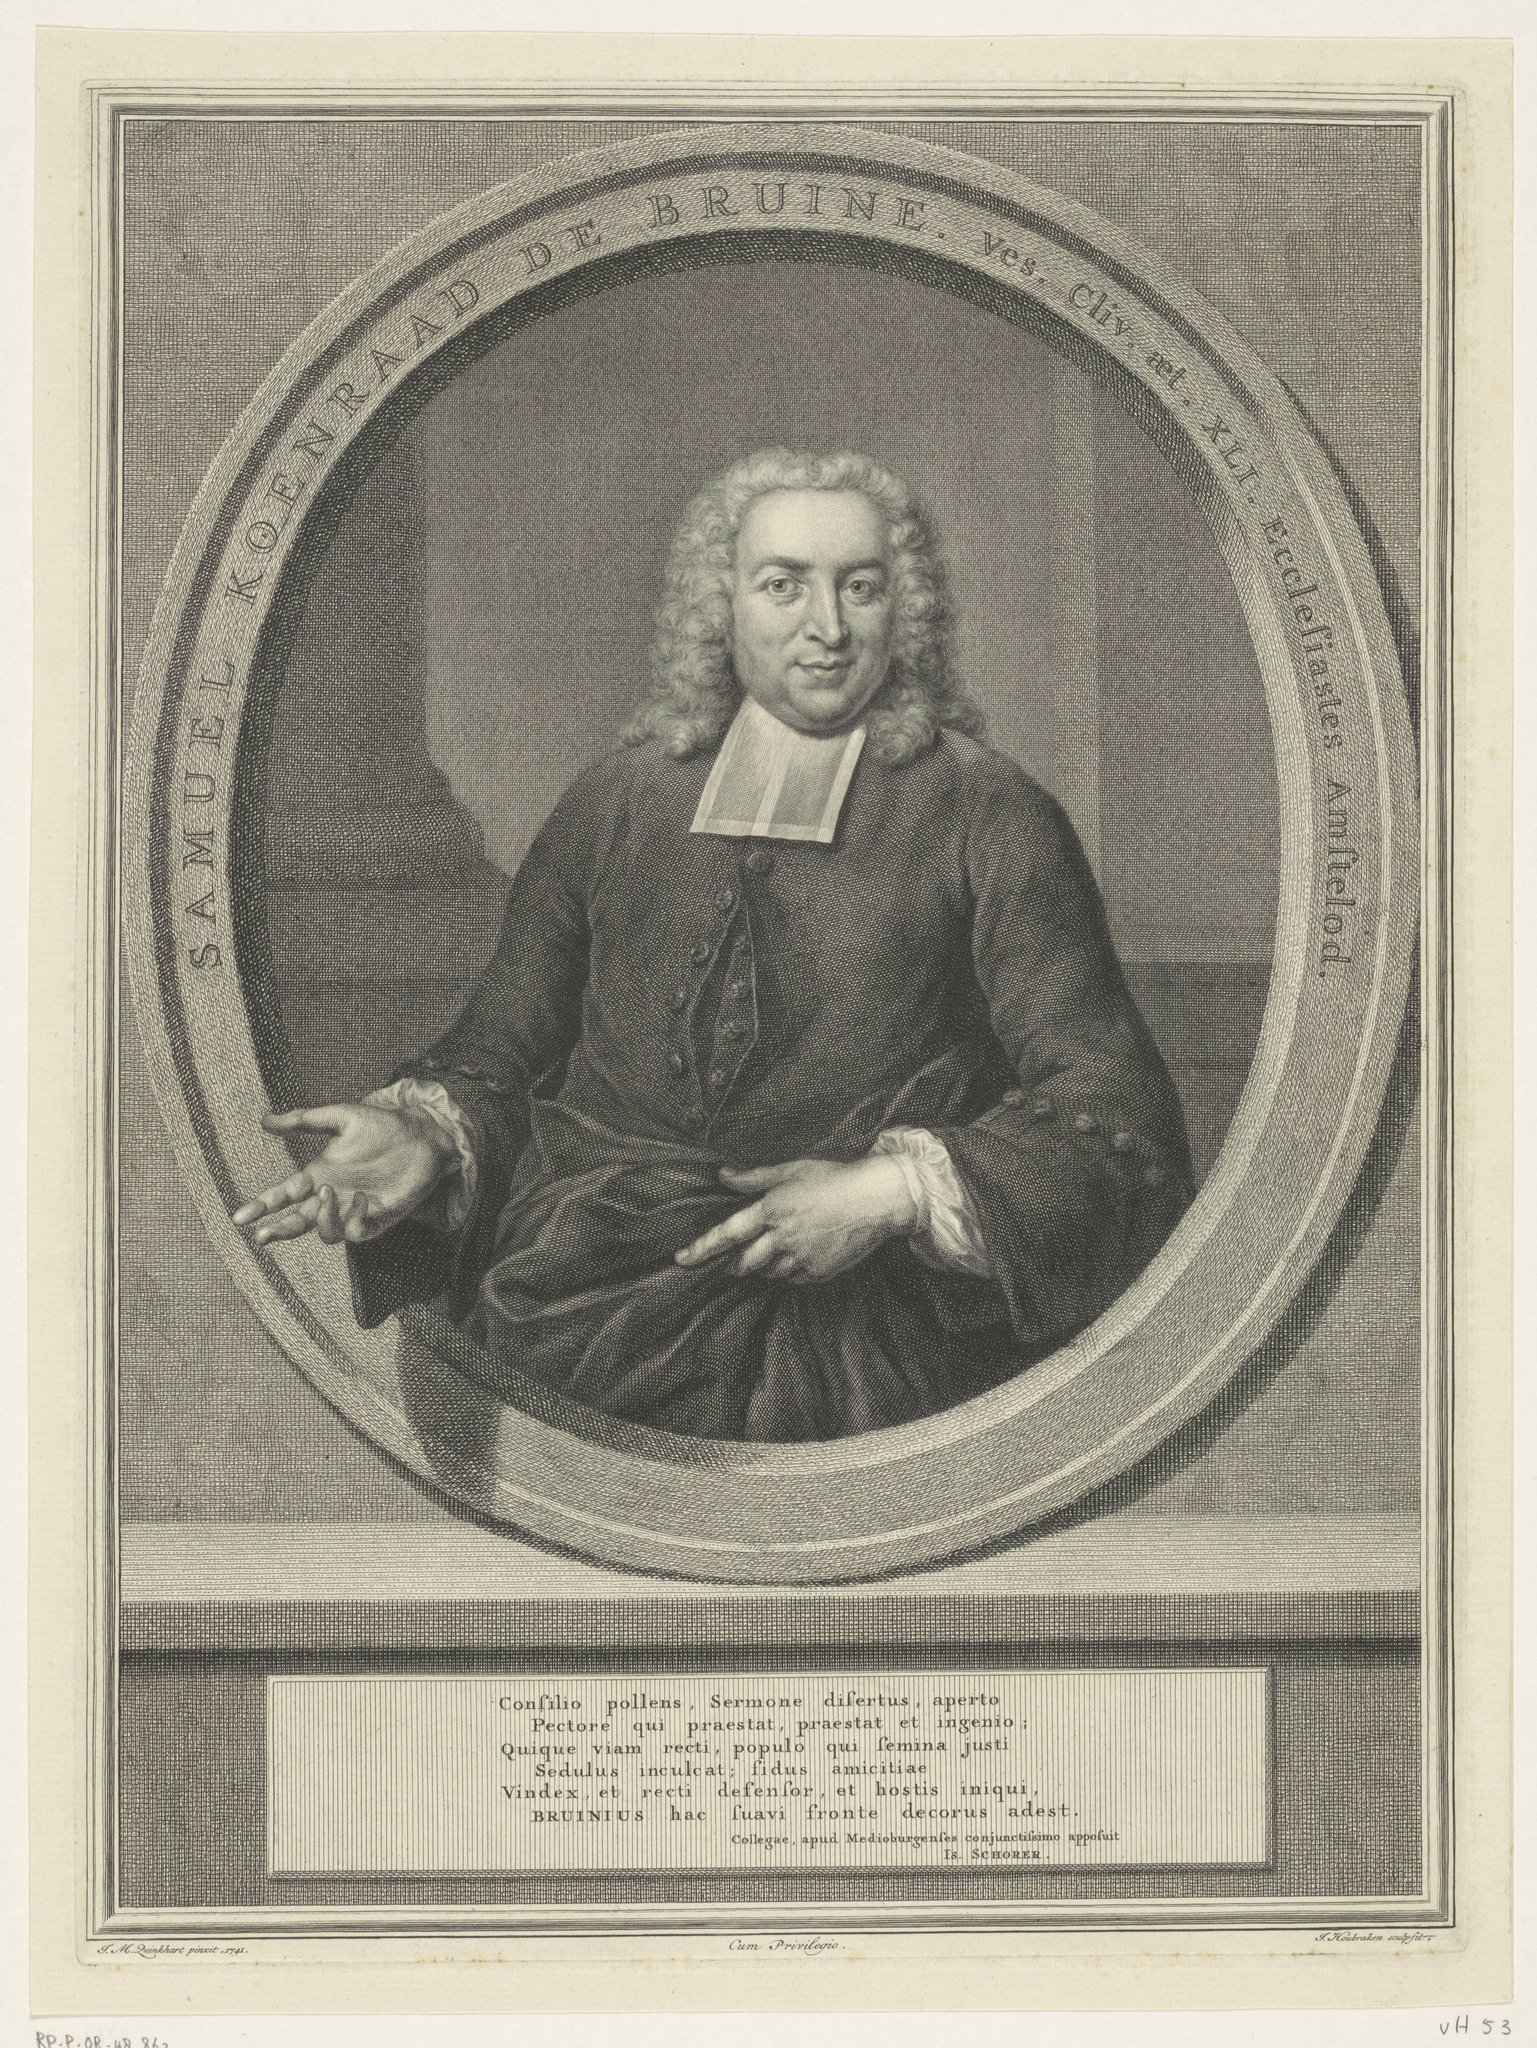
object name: print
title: Portret van Samuel Koenraad de Bruine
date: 1741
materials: paper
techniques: engraving, etching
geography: amsterdam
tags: wezel, predikant, samuel koenraad de bruine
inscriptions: collector's mark: Lugt 240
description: Portret ten halven lijve van Samuel Koenraad de Bruine in een ovaal met randschrift in het Latijn, waarbij zijn rechterhand over de rand steekt. Het portret rust op een plint waarop zes regels in het Latijn.